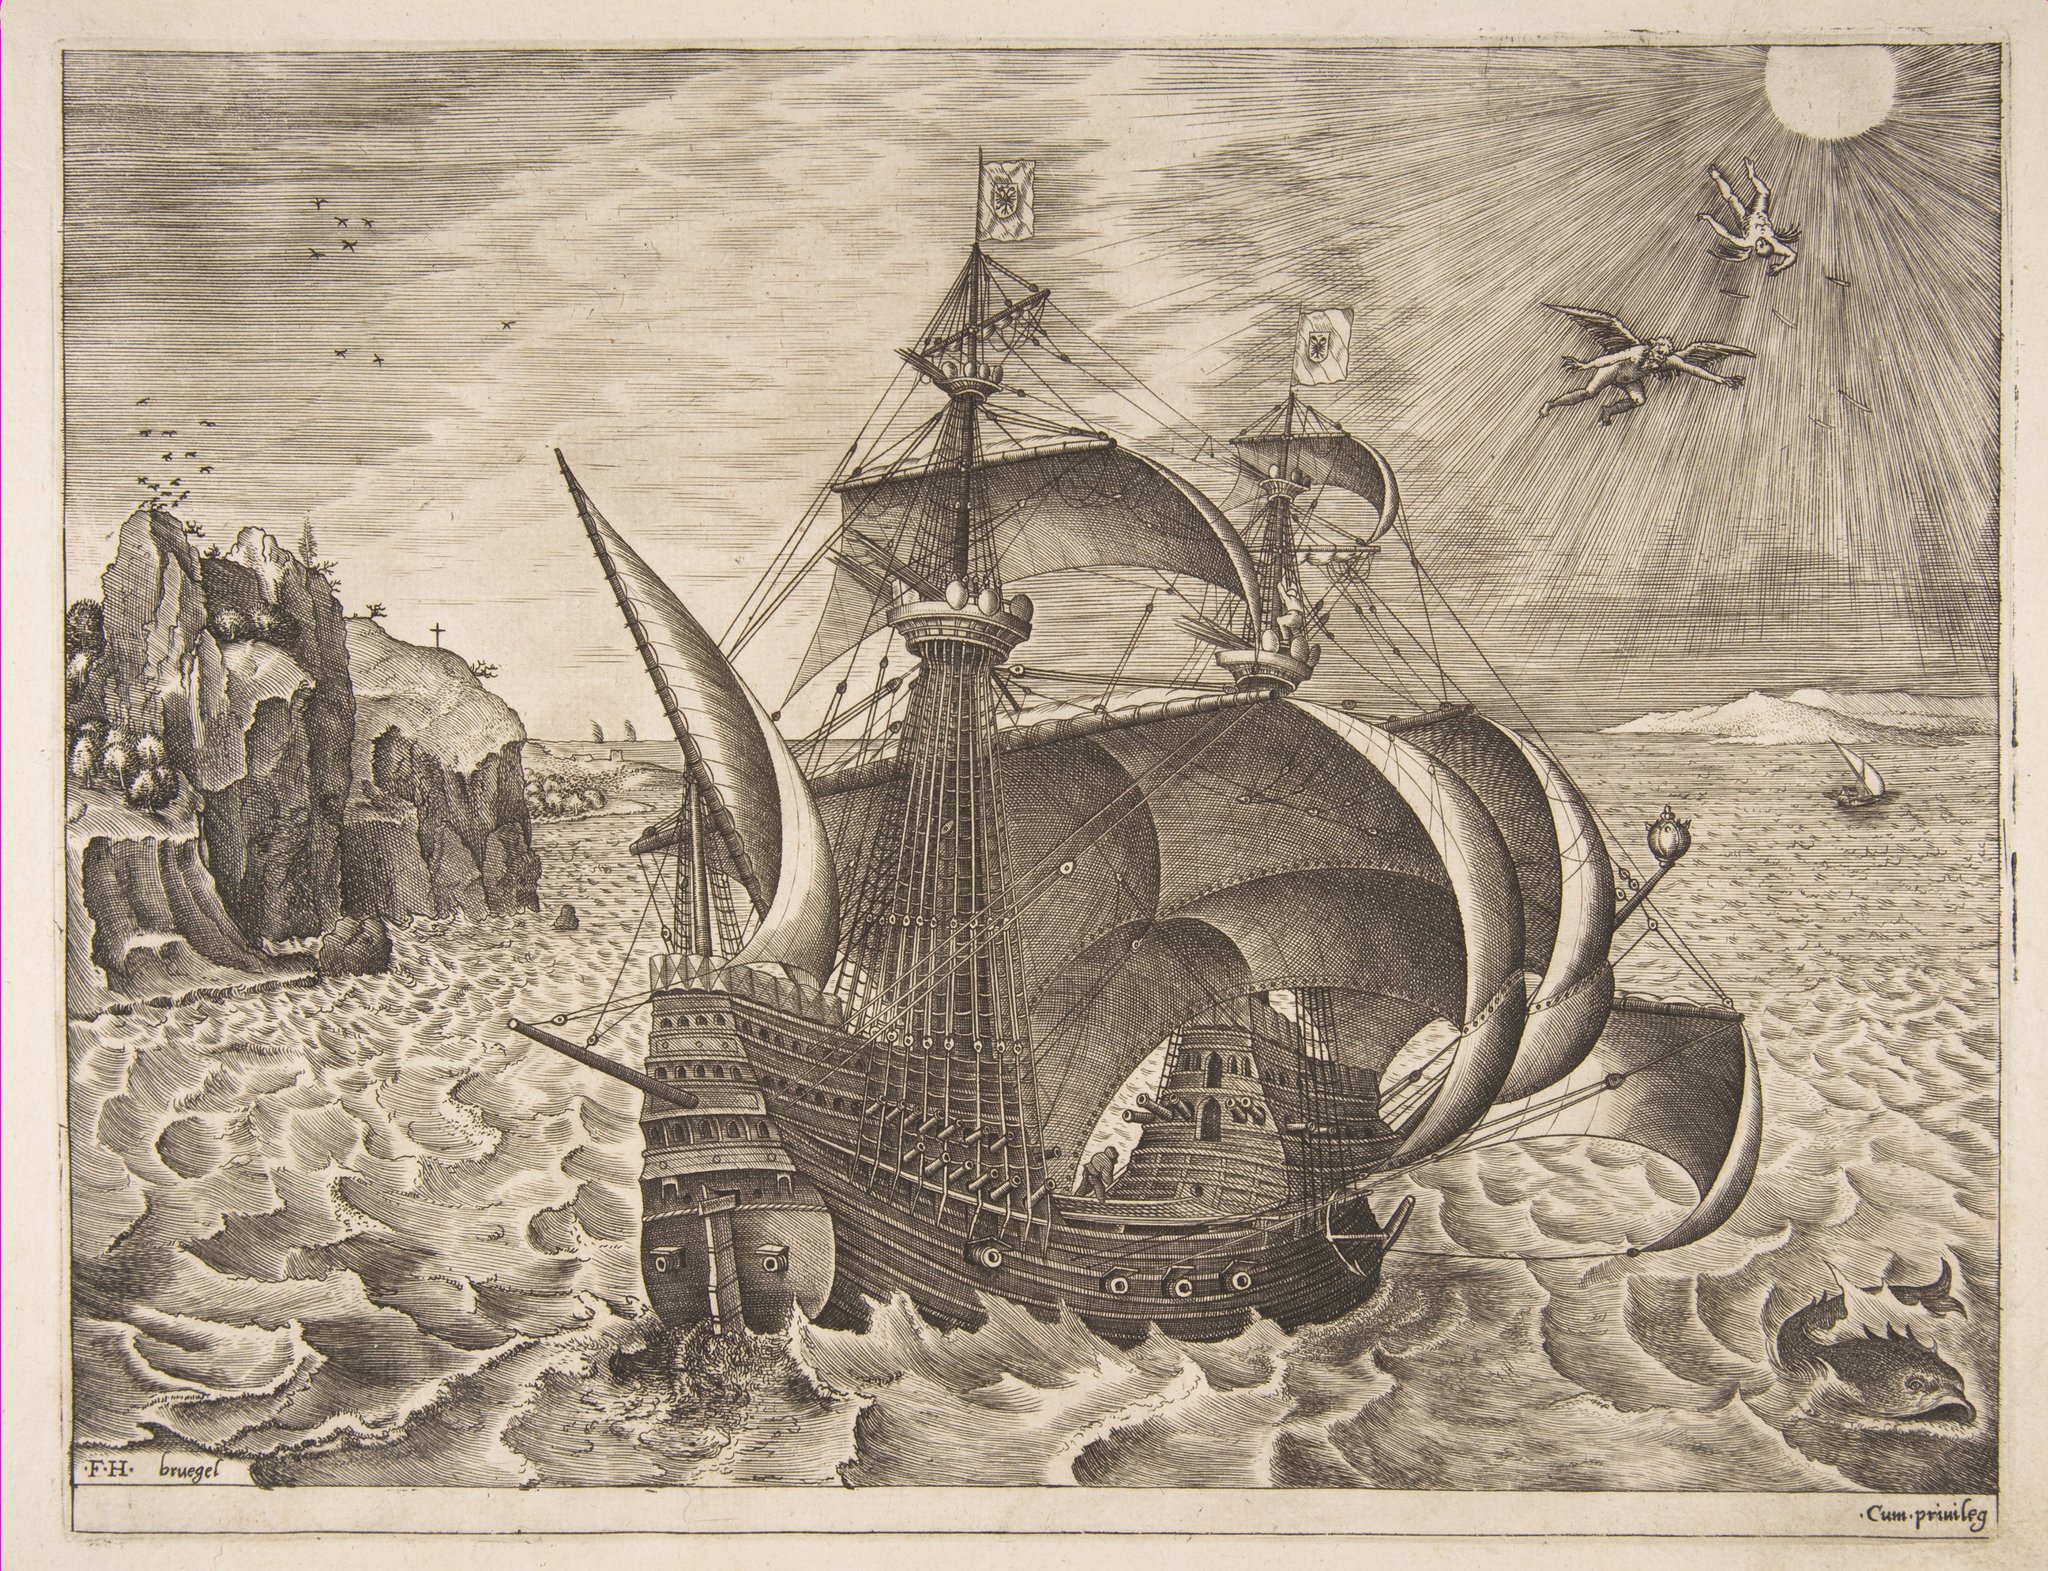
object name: print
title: Armed Three-master with Daedalus and Icarus in the Sky from The Sailing Vessels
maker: pieter bruegel the elder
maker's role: artist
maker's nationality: netherlandish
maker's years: 1525-1569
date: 1561-1565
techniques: engraving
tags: waves,ships